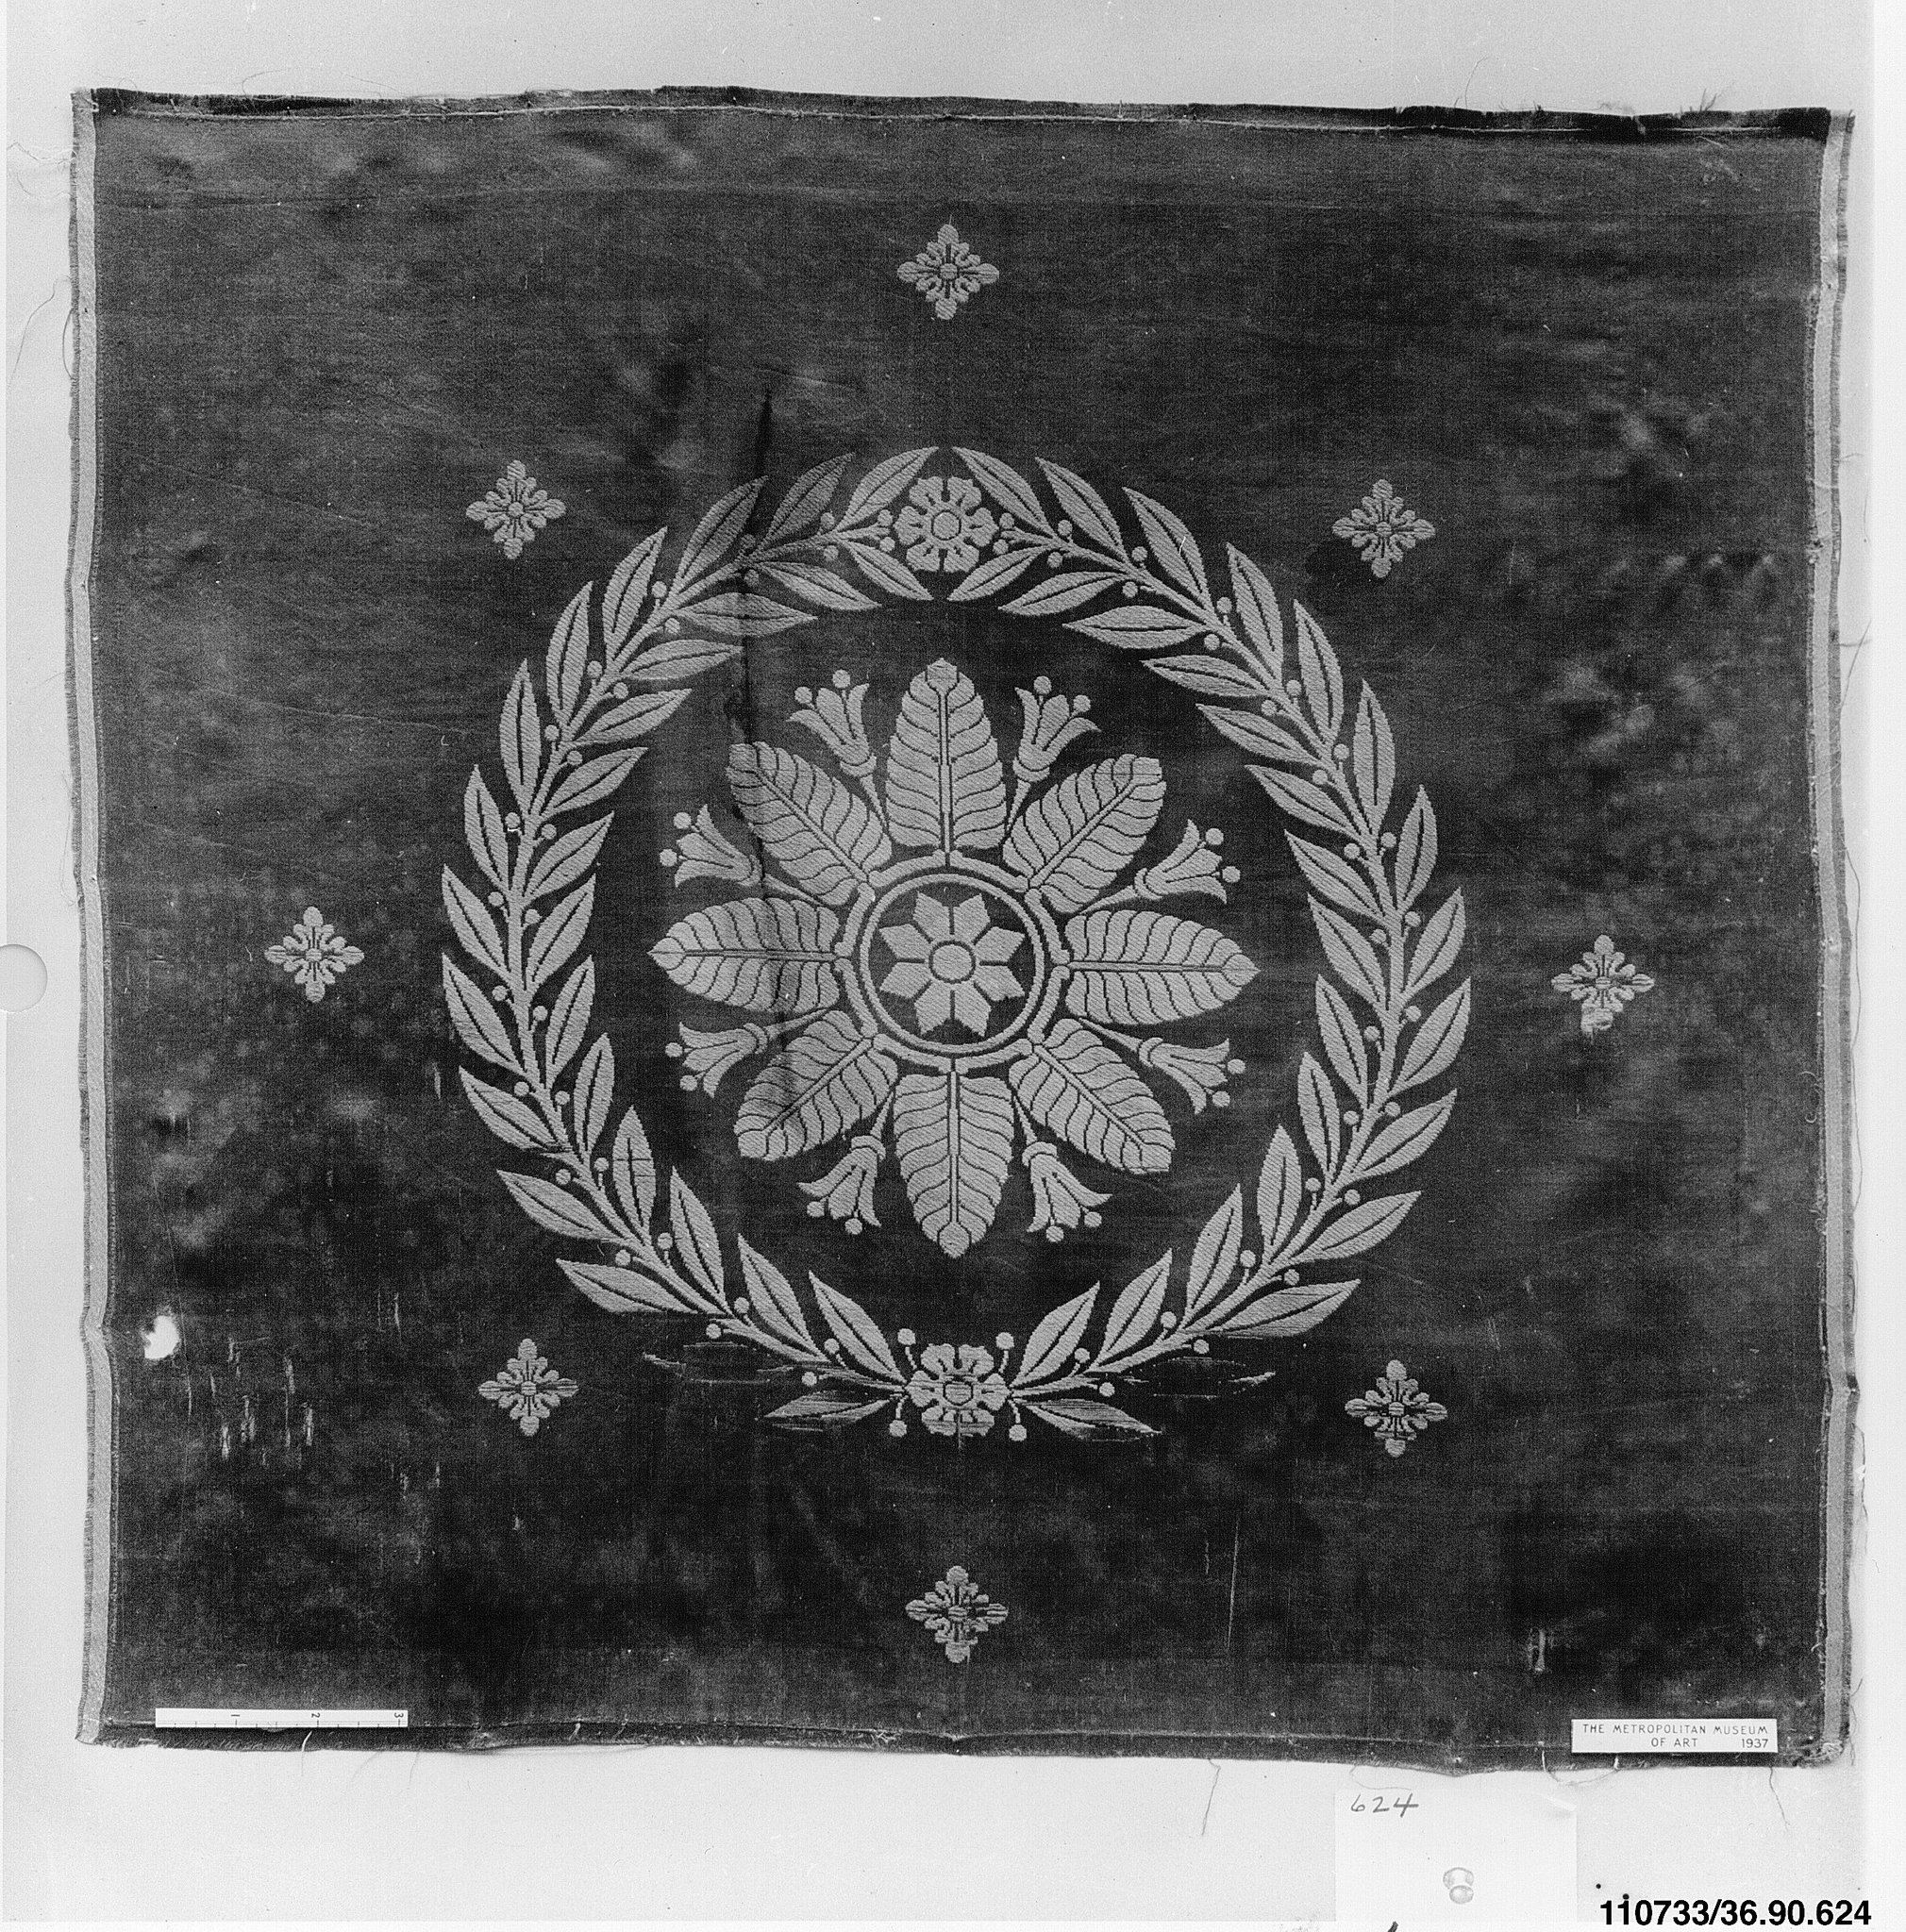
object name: piece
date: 1805-1815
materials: silk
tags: flowers,wreaths